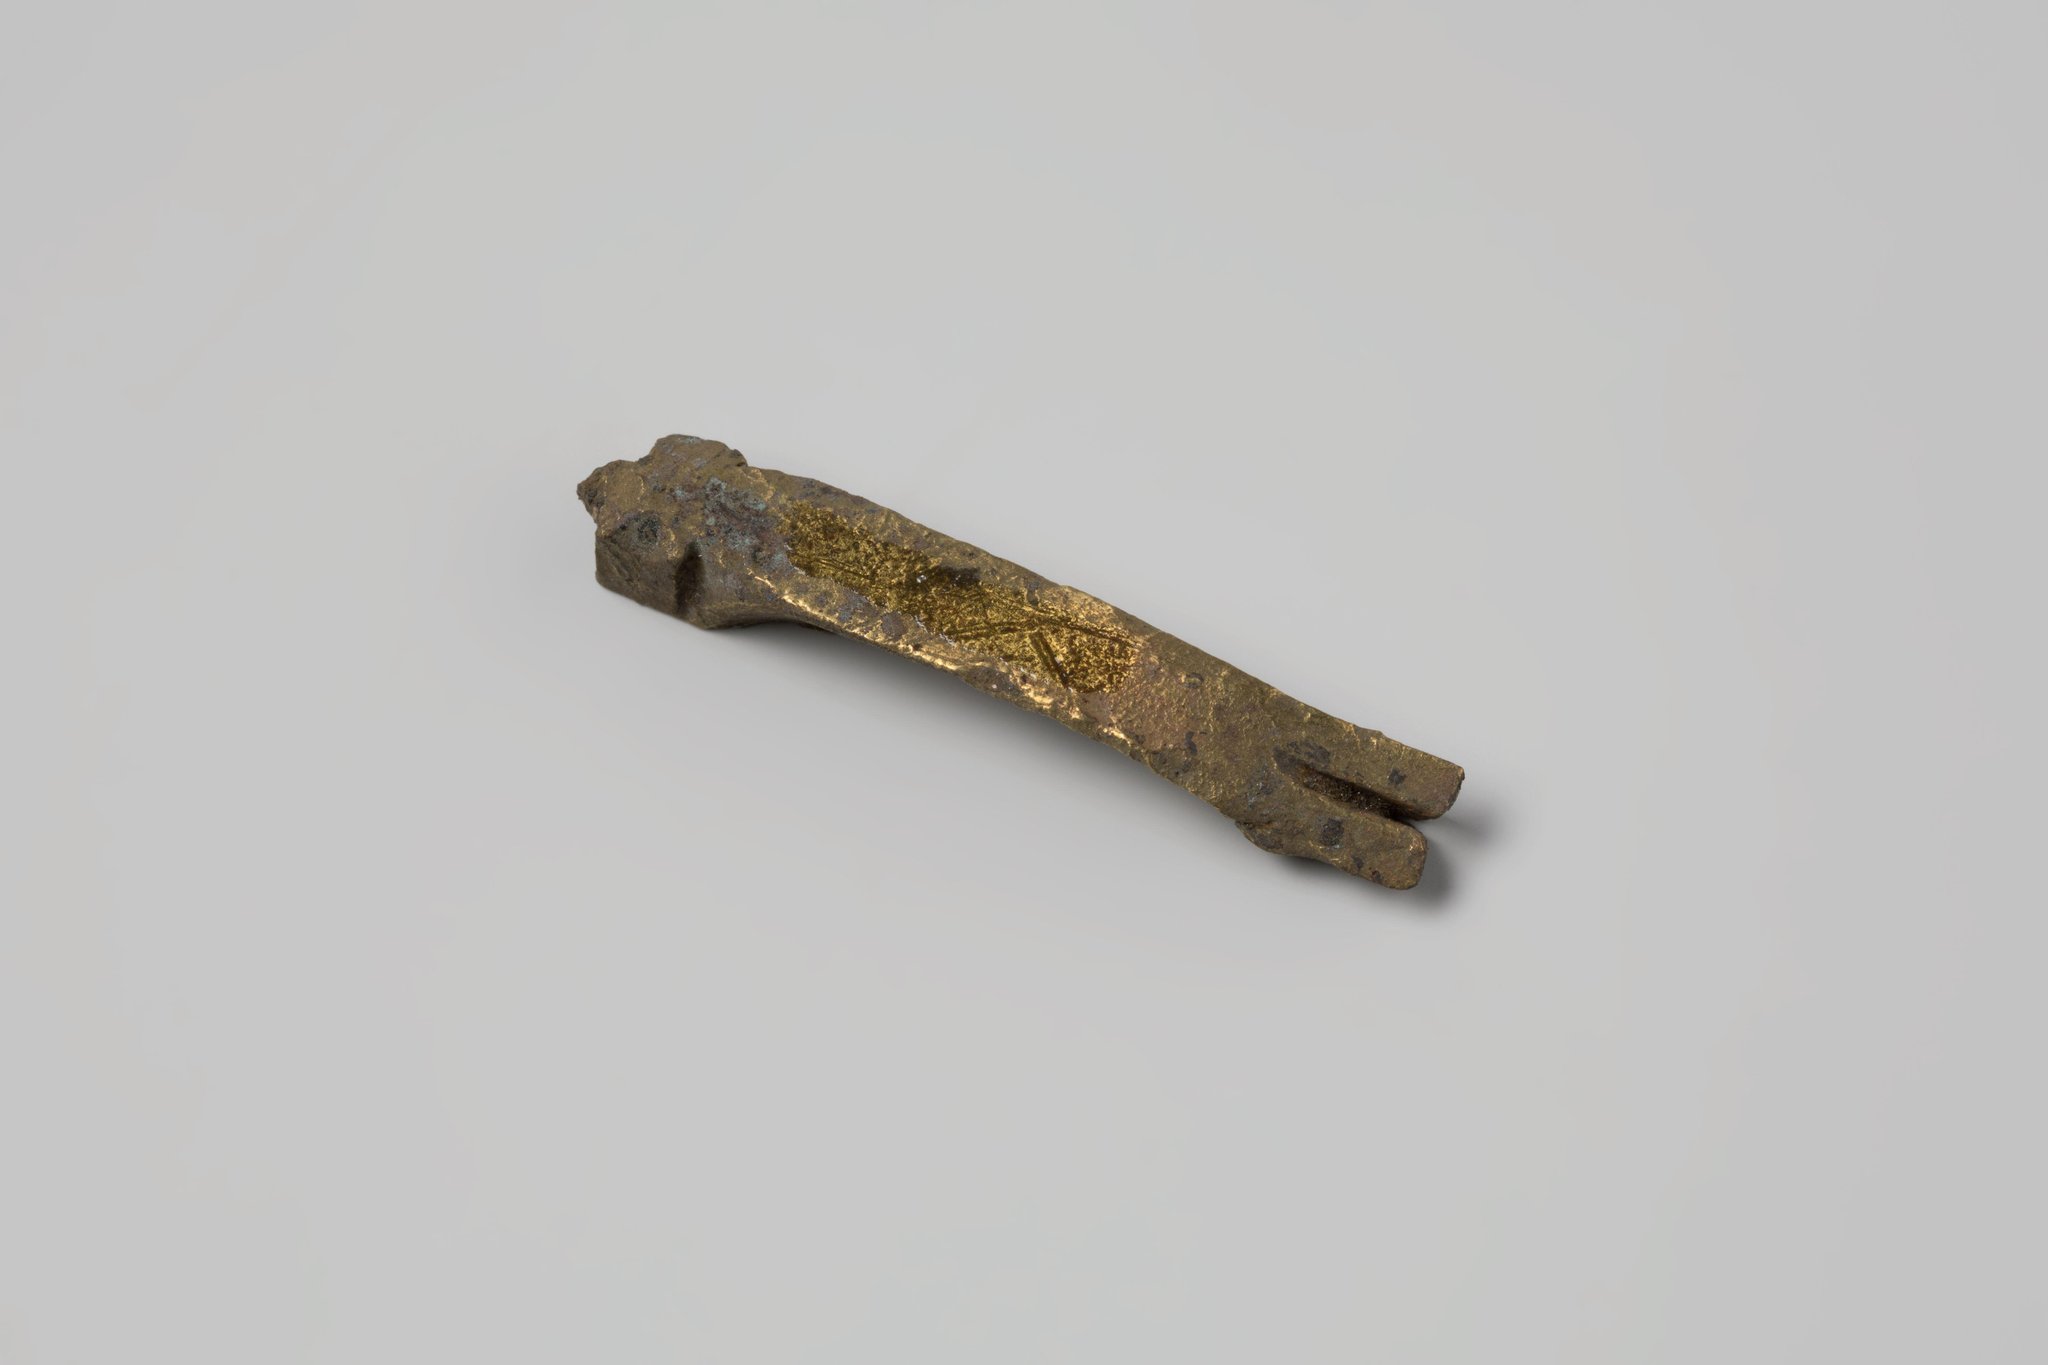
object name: divider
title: Fragment steekpasser uit het wrak van de Oost-Indiëvaarder Hollandia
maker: Anonymous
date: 1700-1743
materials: copper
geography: netherlands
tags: verenigde oostindische compagnie, hollandia (schip), annet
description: Divider; fragment, leg, id. NG 1980-27H1171.